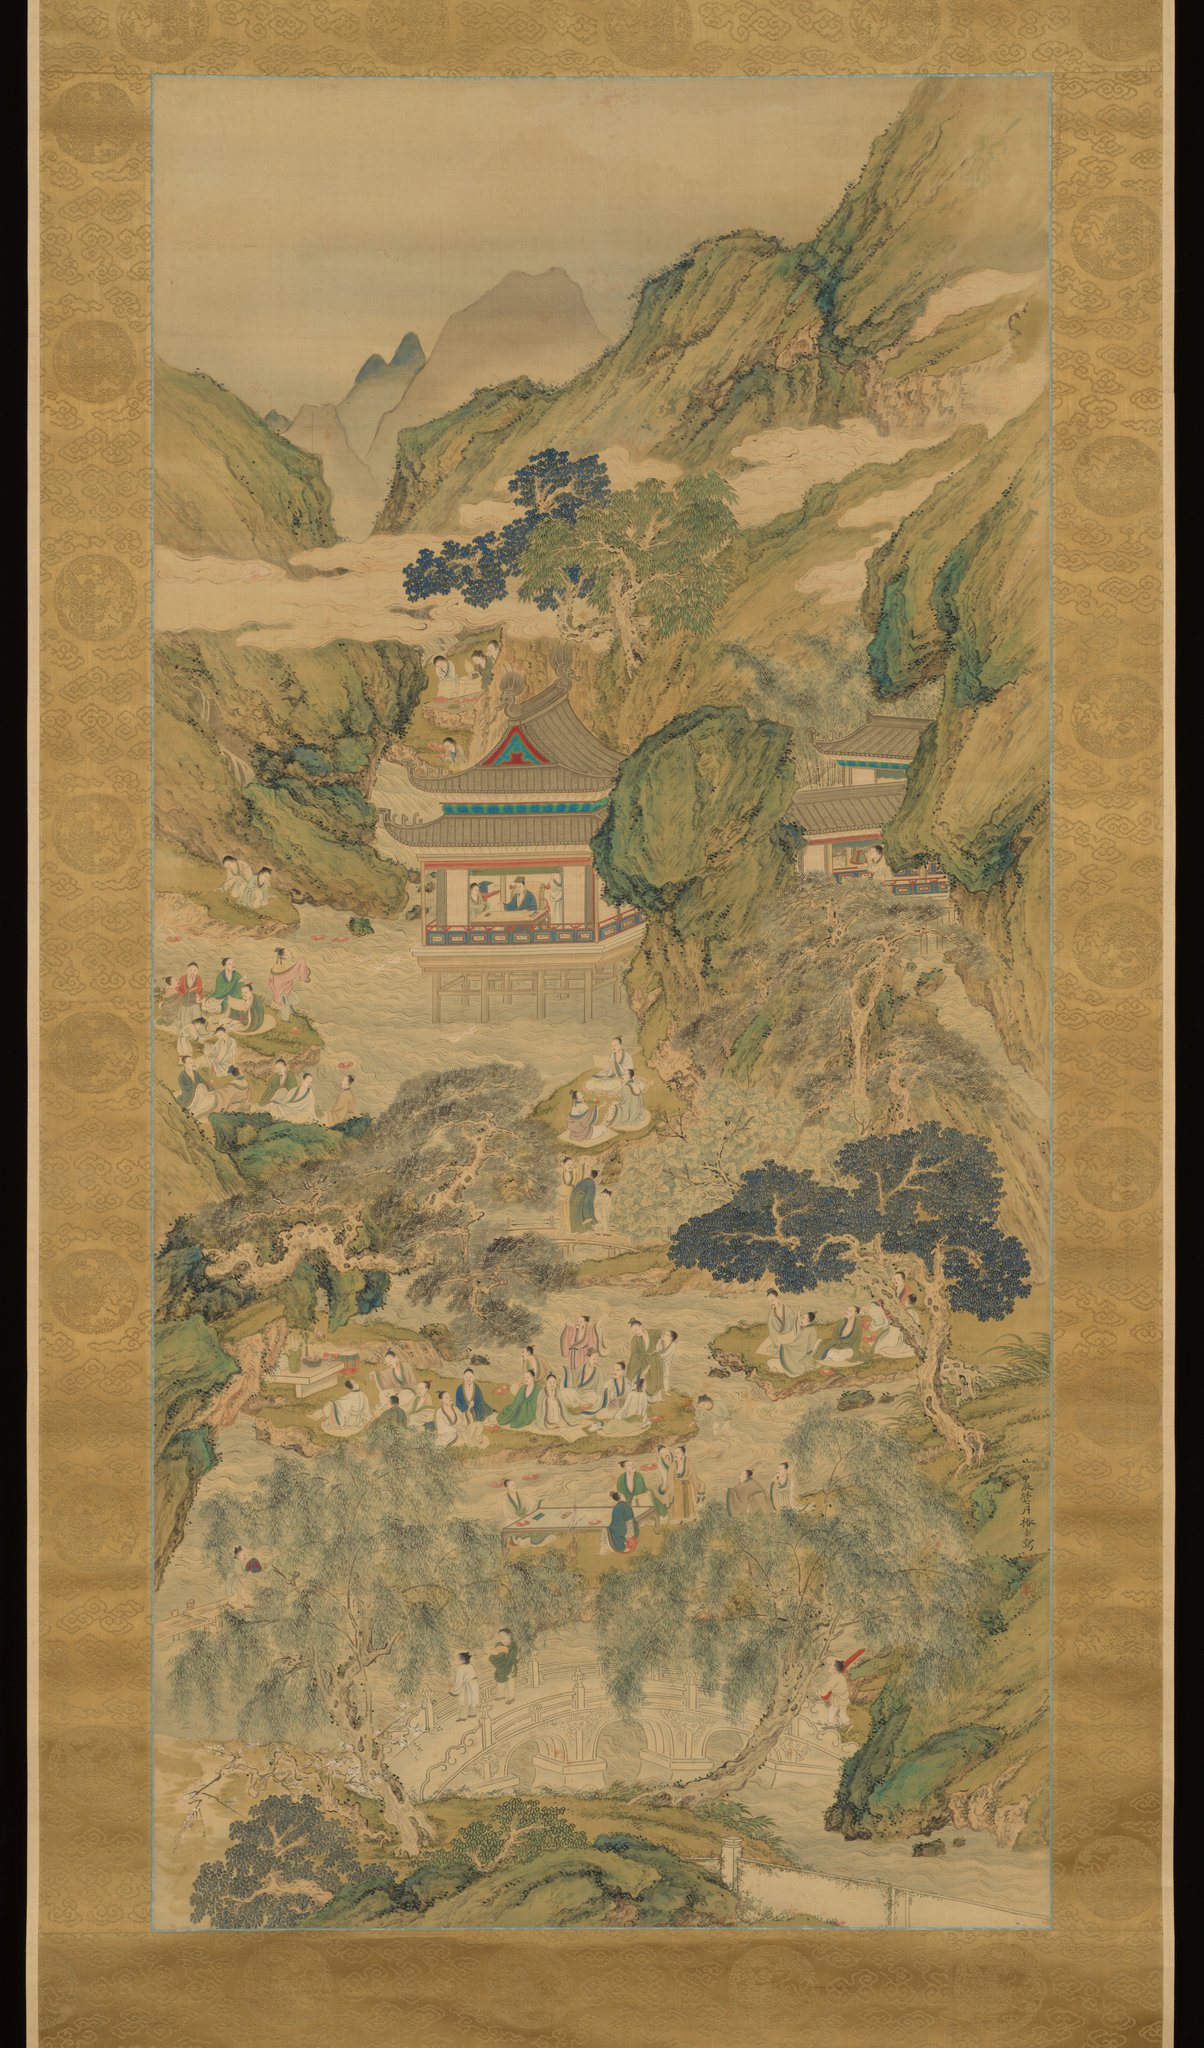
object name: hanging scroll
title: Orchid Pavilion Gathering in Blue and Green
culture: japanese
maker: tsubaki kakoku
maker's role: artist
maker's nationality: japanese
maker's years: 1825-1850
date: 1844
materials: ink, silk